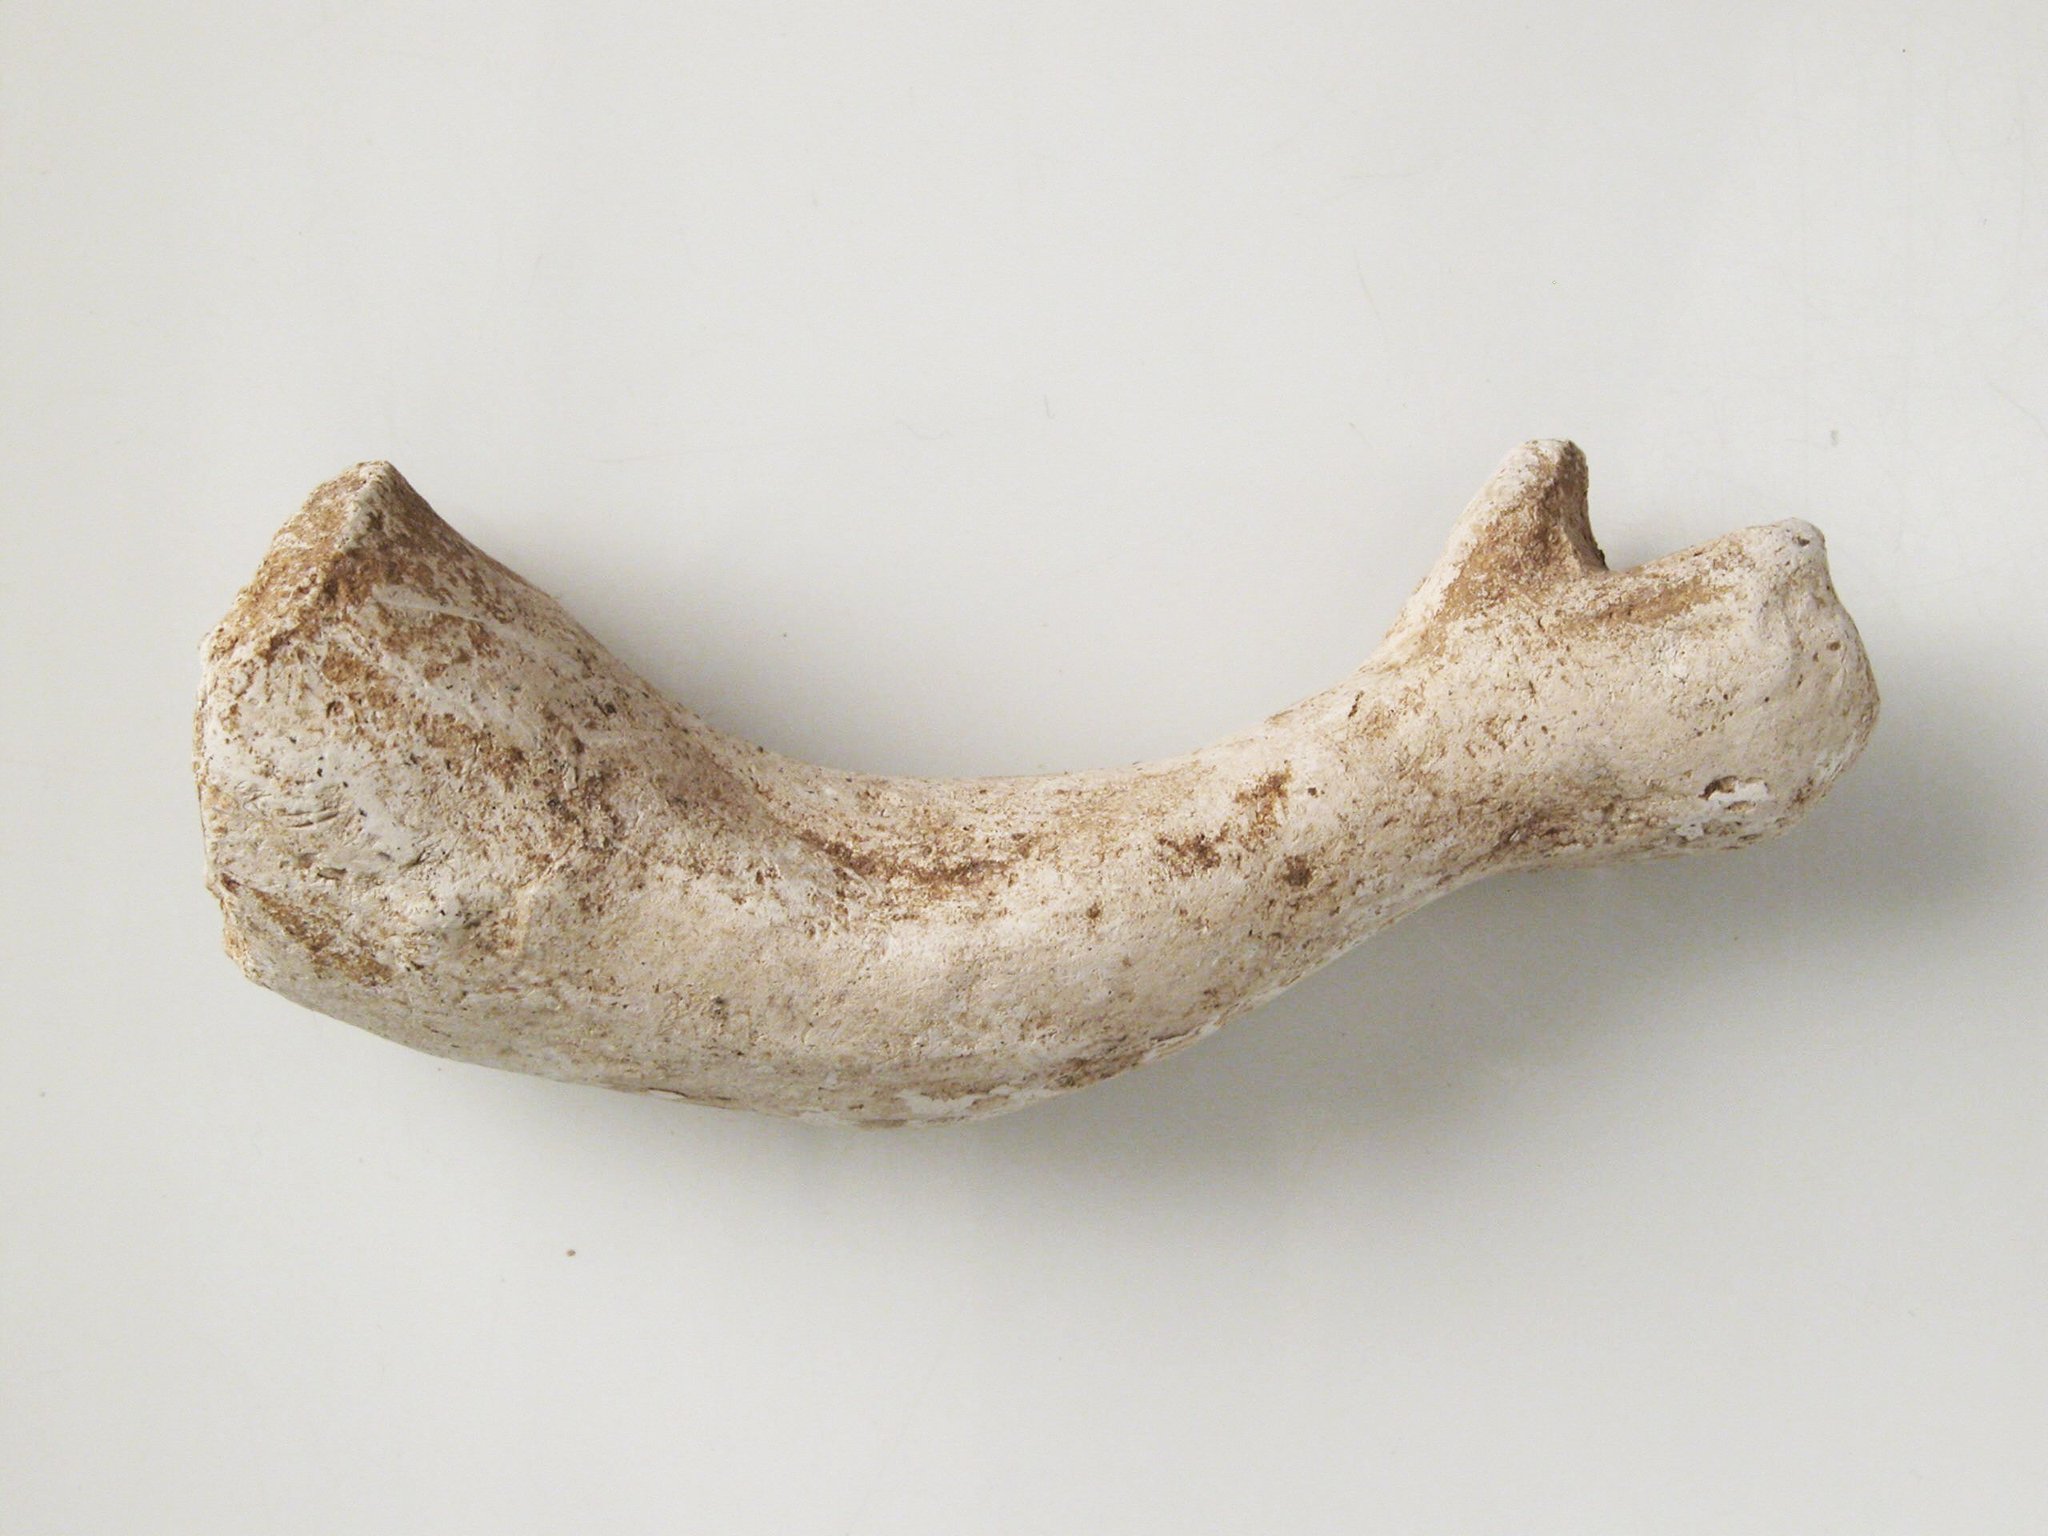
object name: statuette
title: Arm Fragment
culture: coptic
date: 301-700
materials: plaster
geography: egypt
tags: hands